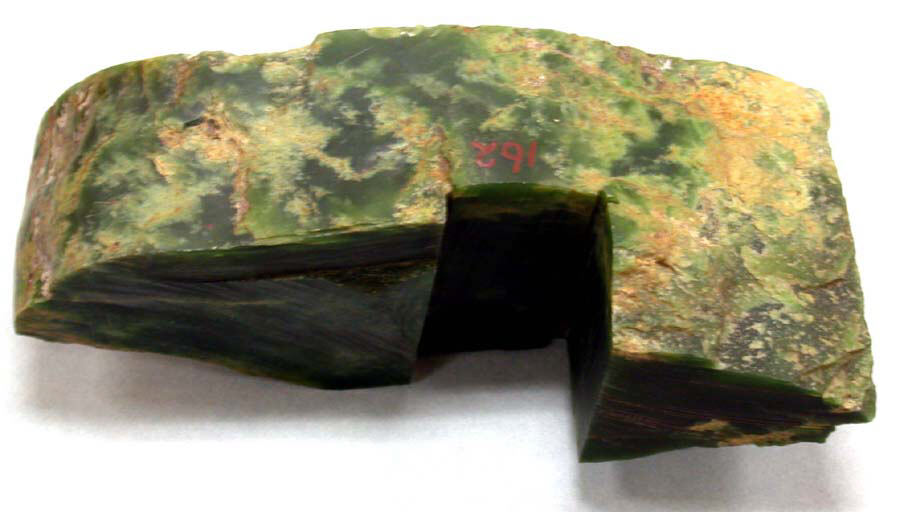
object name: fragment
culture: new zealander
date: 1902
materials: jade